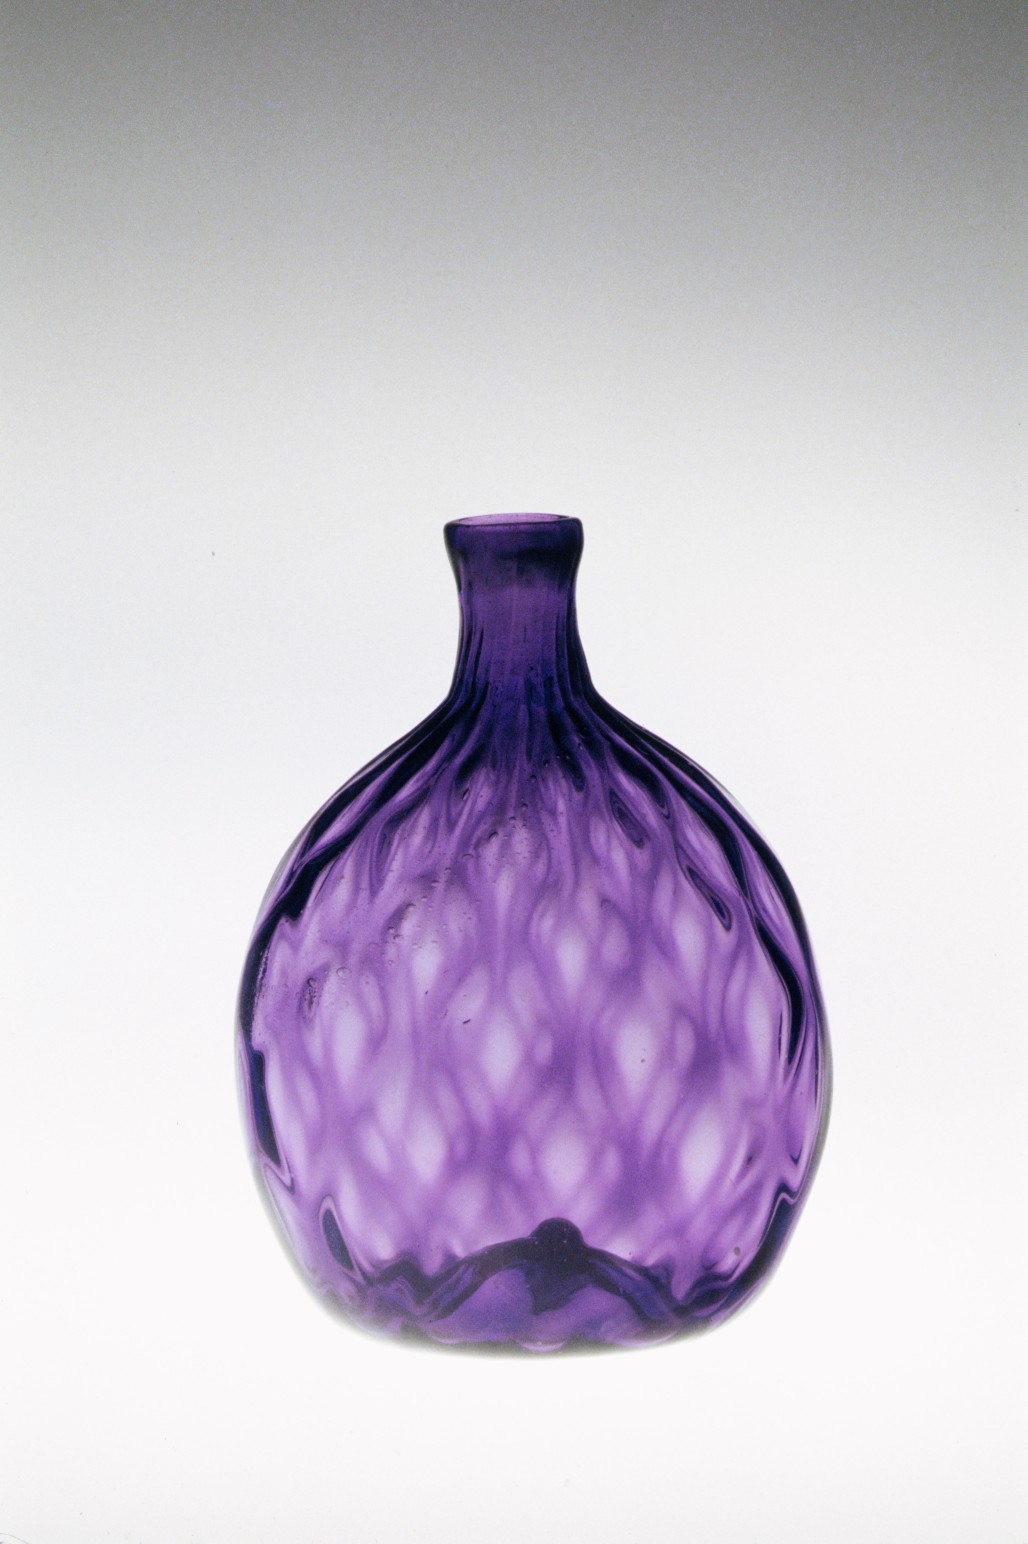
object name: pocket flask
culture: american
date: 1800-1860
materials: glass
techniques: glassblowing, molding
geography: united states